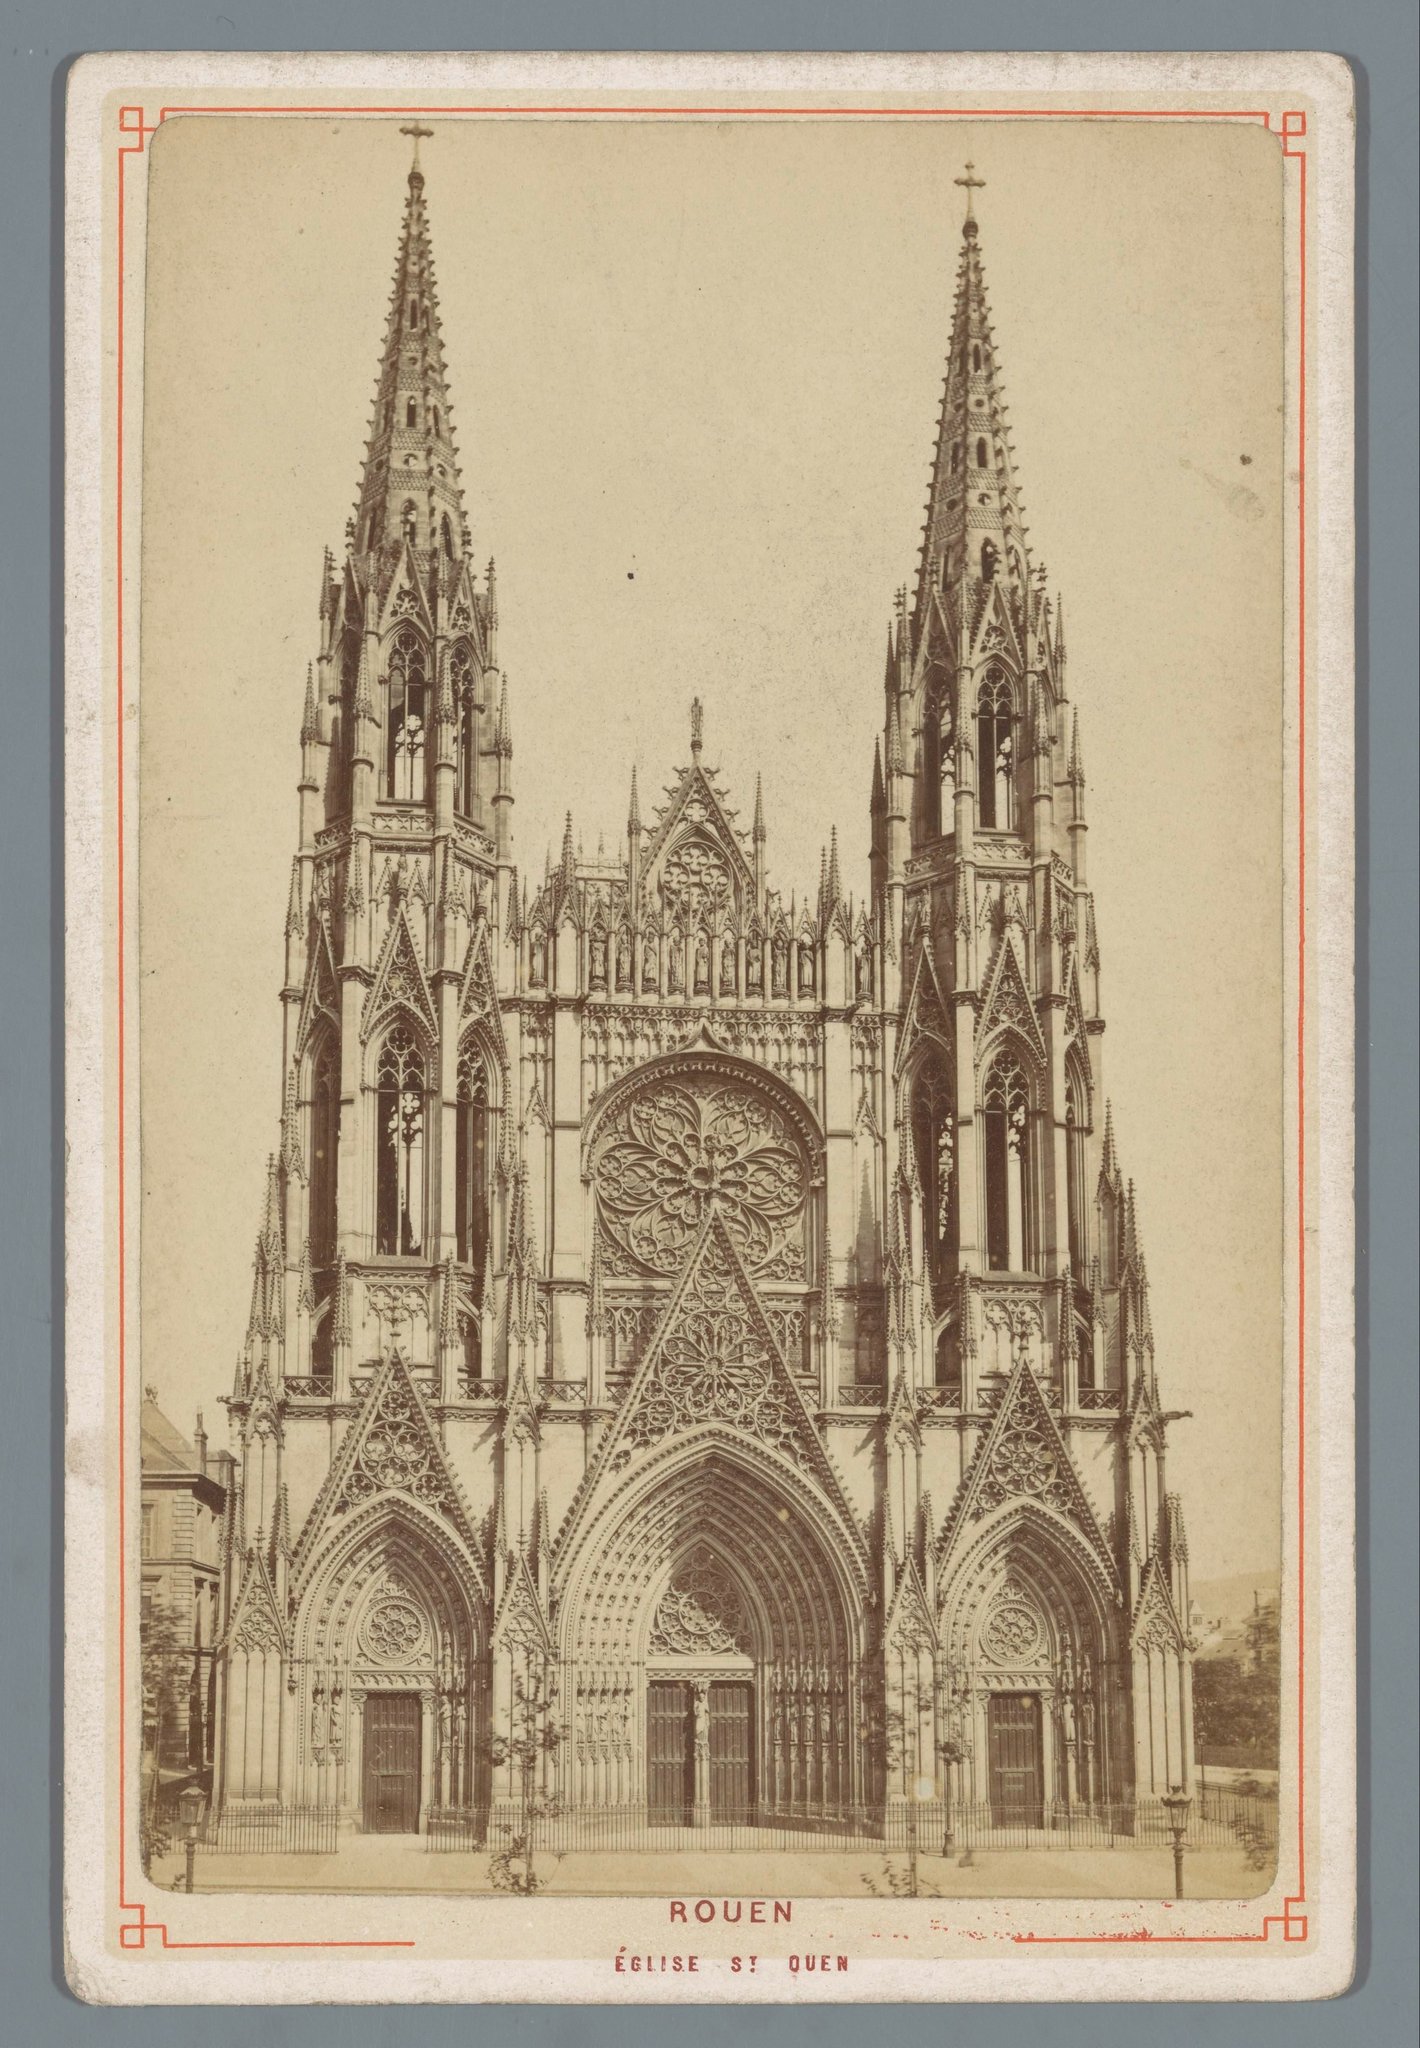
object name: cabinet photograph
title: Église St Ouen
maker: étienne neurdein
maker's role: publisher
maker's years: 1832-1918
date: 1870-1900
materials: cardboard, photographic support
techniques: albumen print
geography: rouen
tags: church (exterior), façade (of house or building)